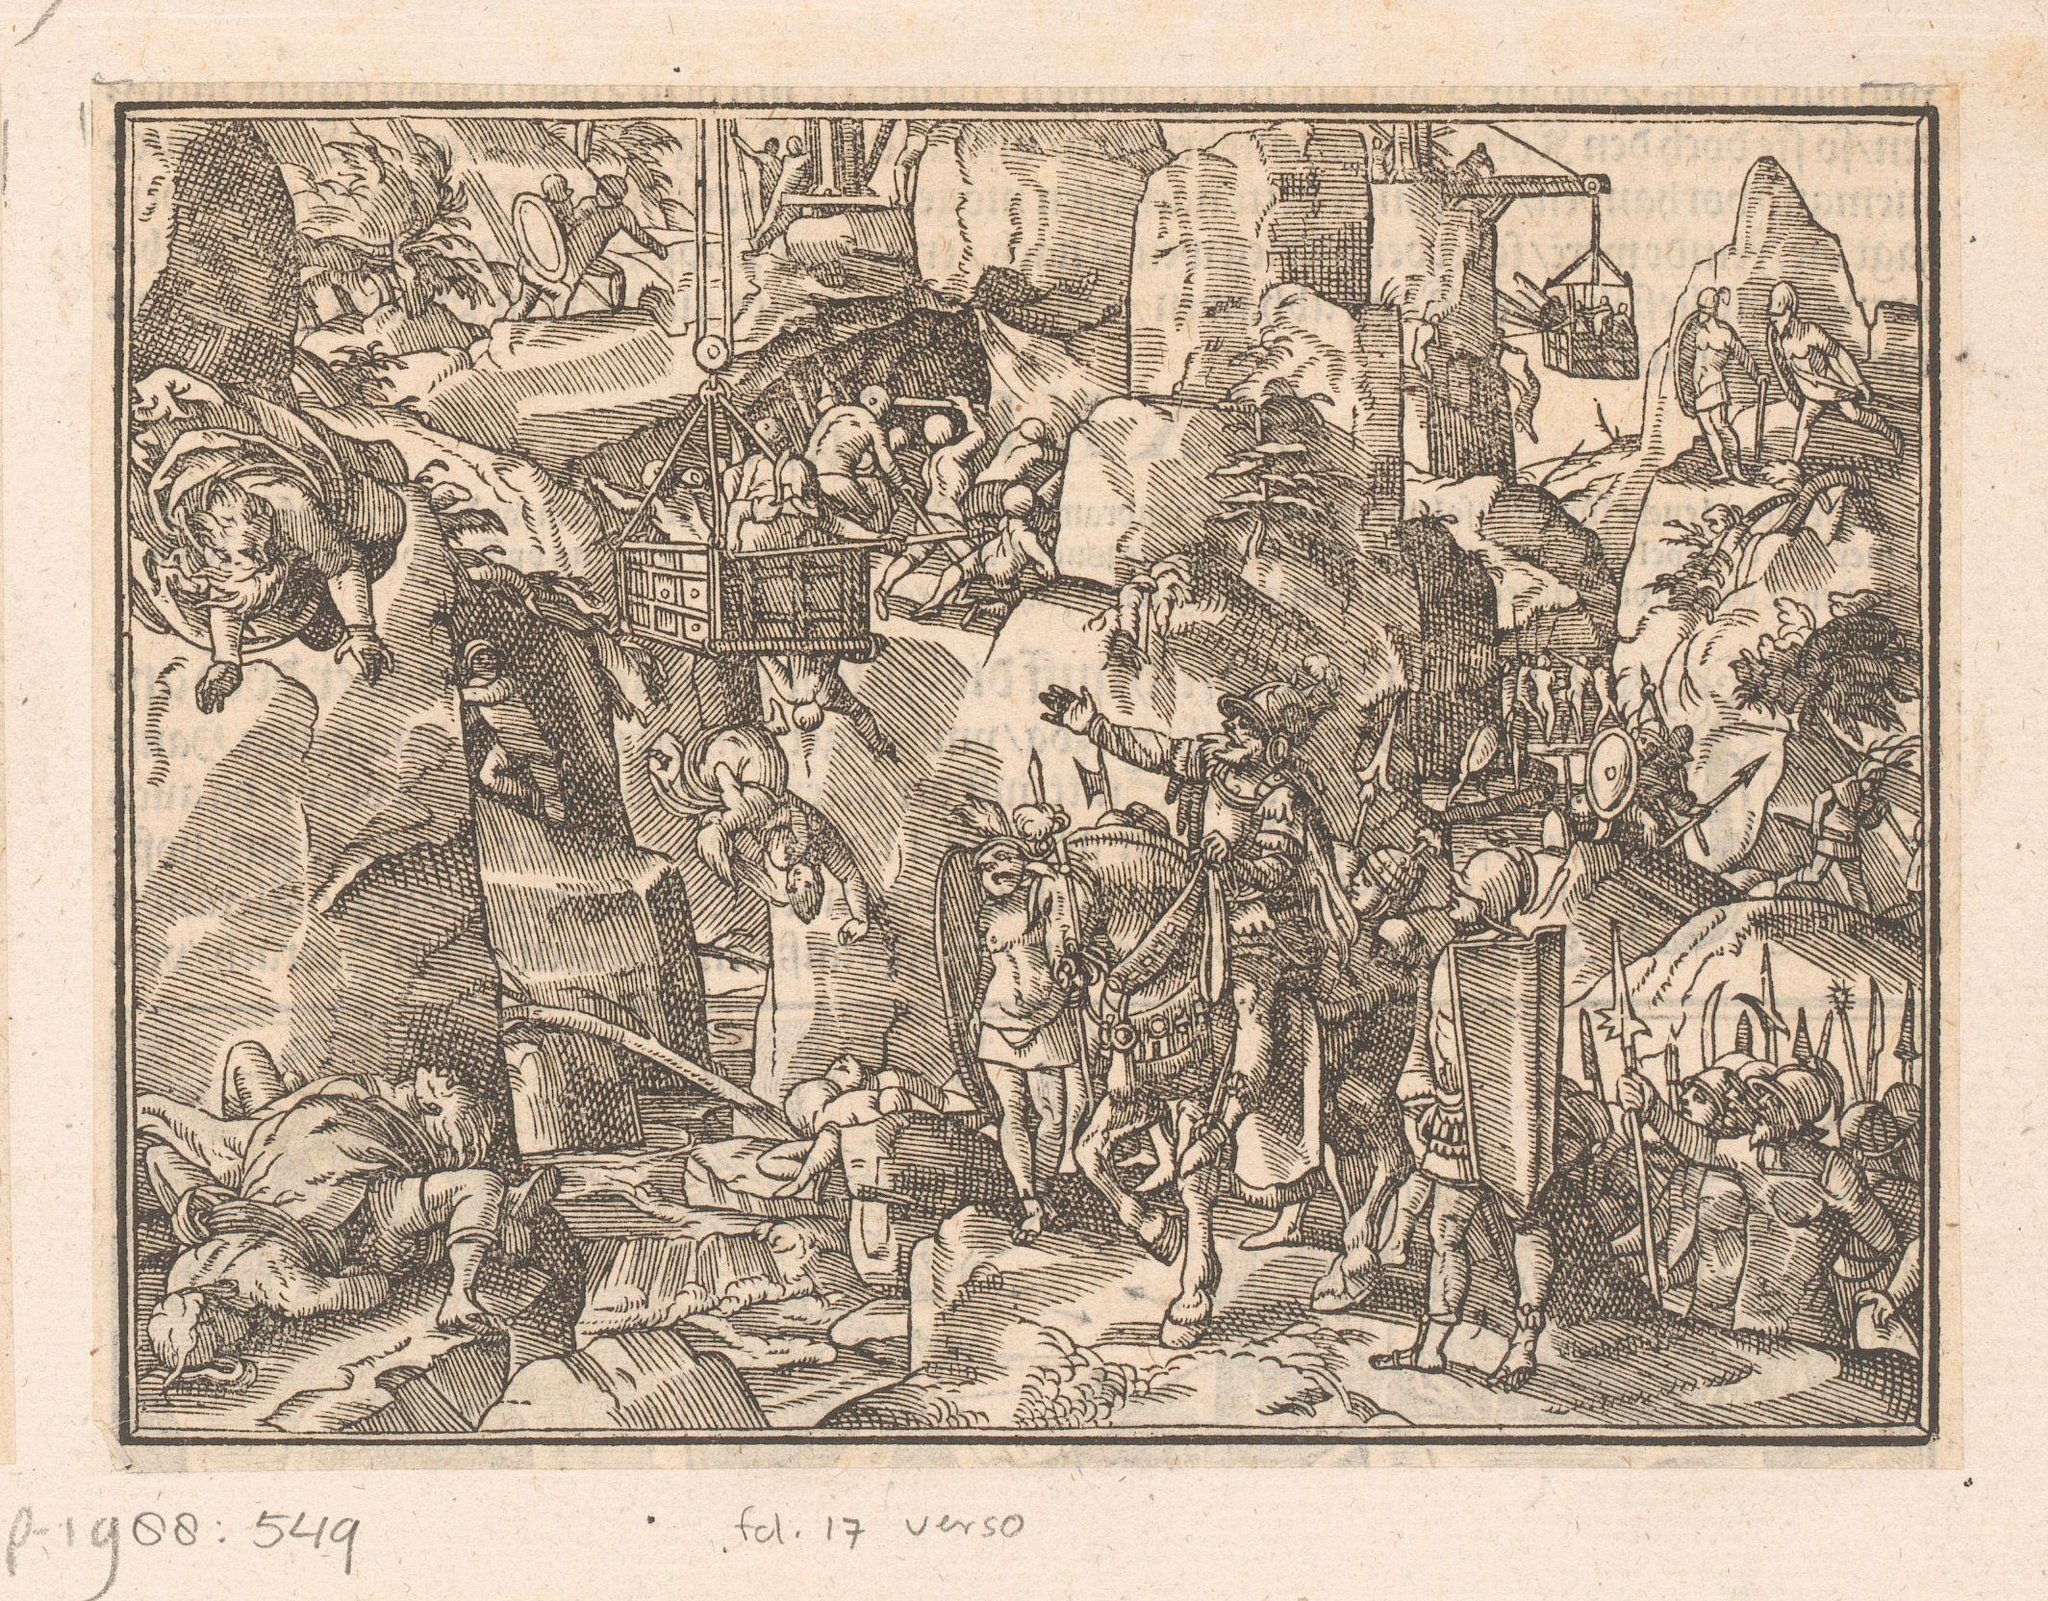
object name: print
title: Soldaten van Herodes in manden bevechten de bandieten in hun grotten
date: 1574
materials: paper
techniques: woodcut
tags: the five amorite kings escape and hide in the cave of makkedah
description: Prent voor het eerst gebruikt in: Josephus, Flavius. Historien und Bücher von Alten Jüdischen Geschichten. Straatsburg: Theodosius Rihel, 1574.